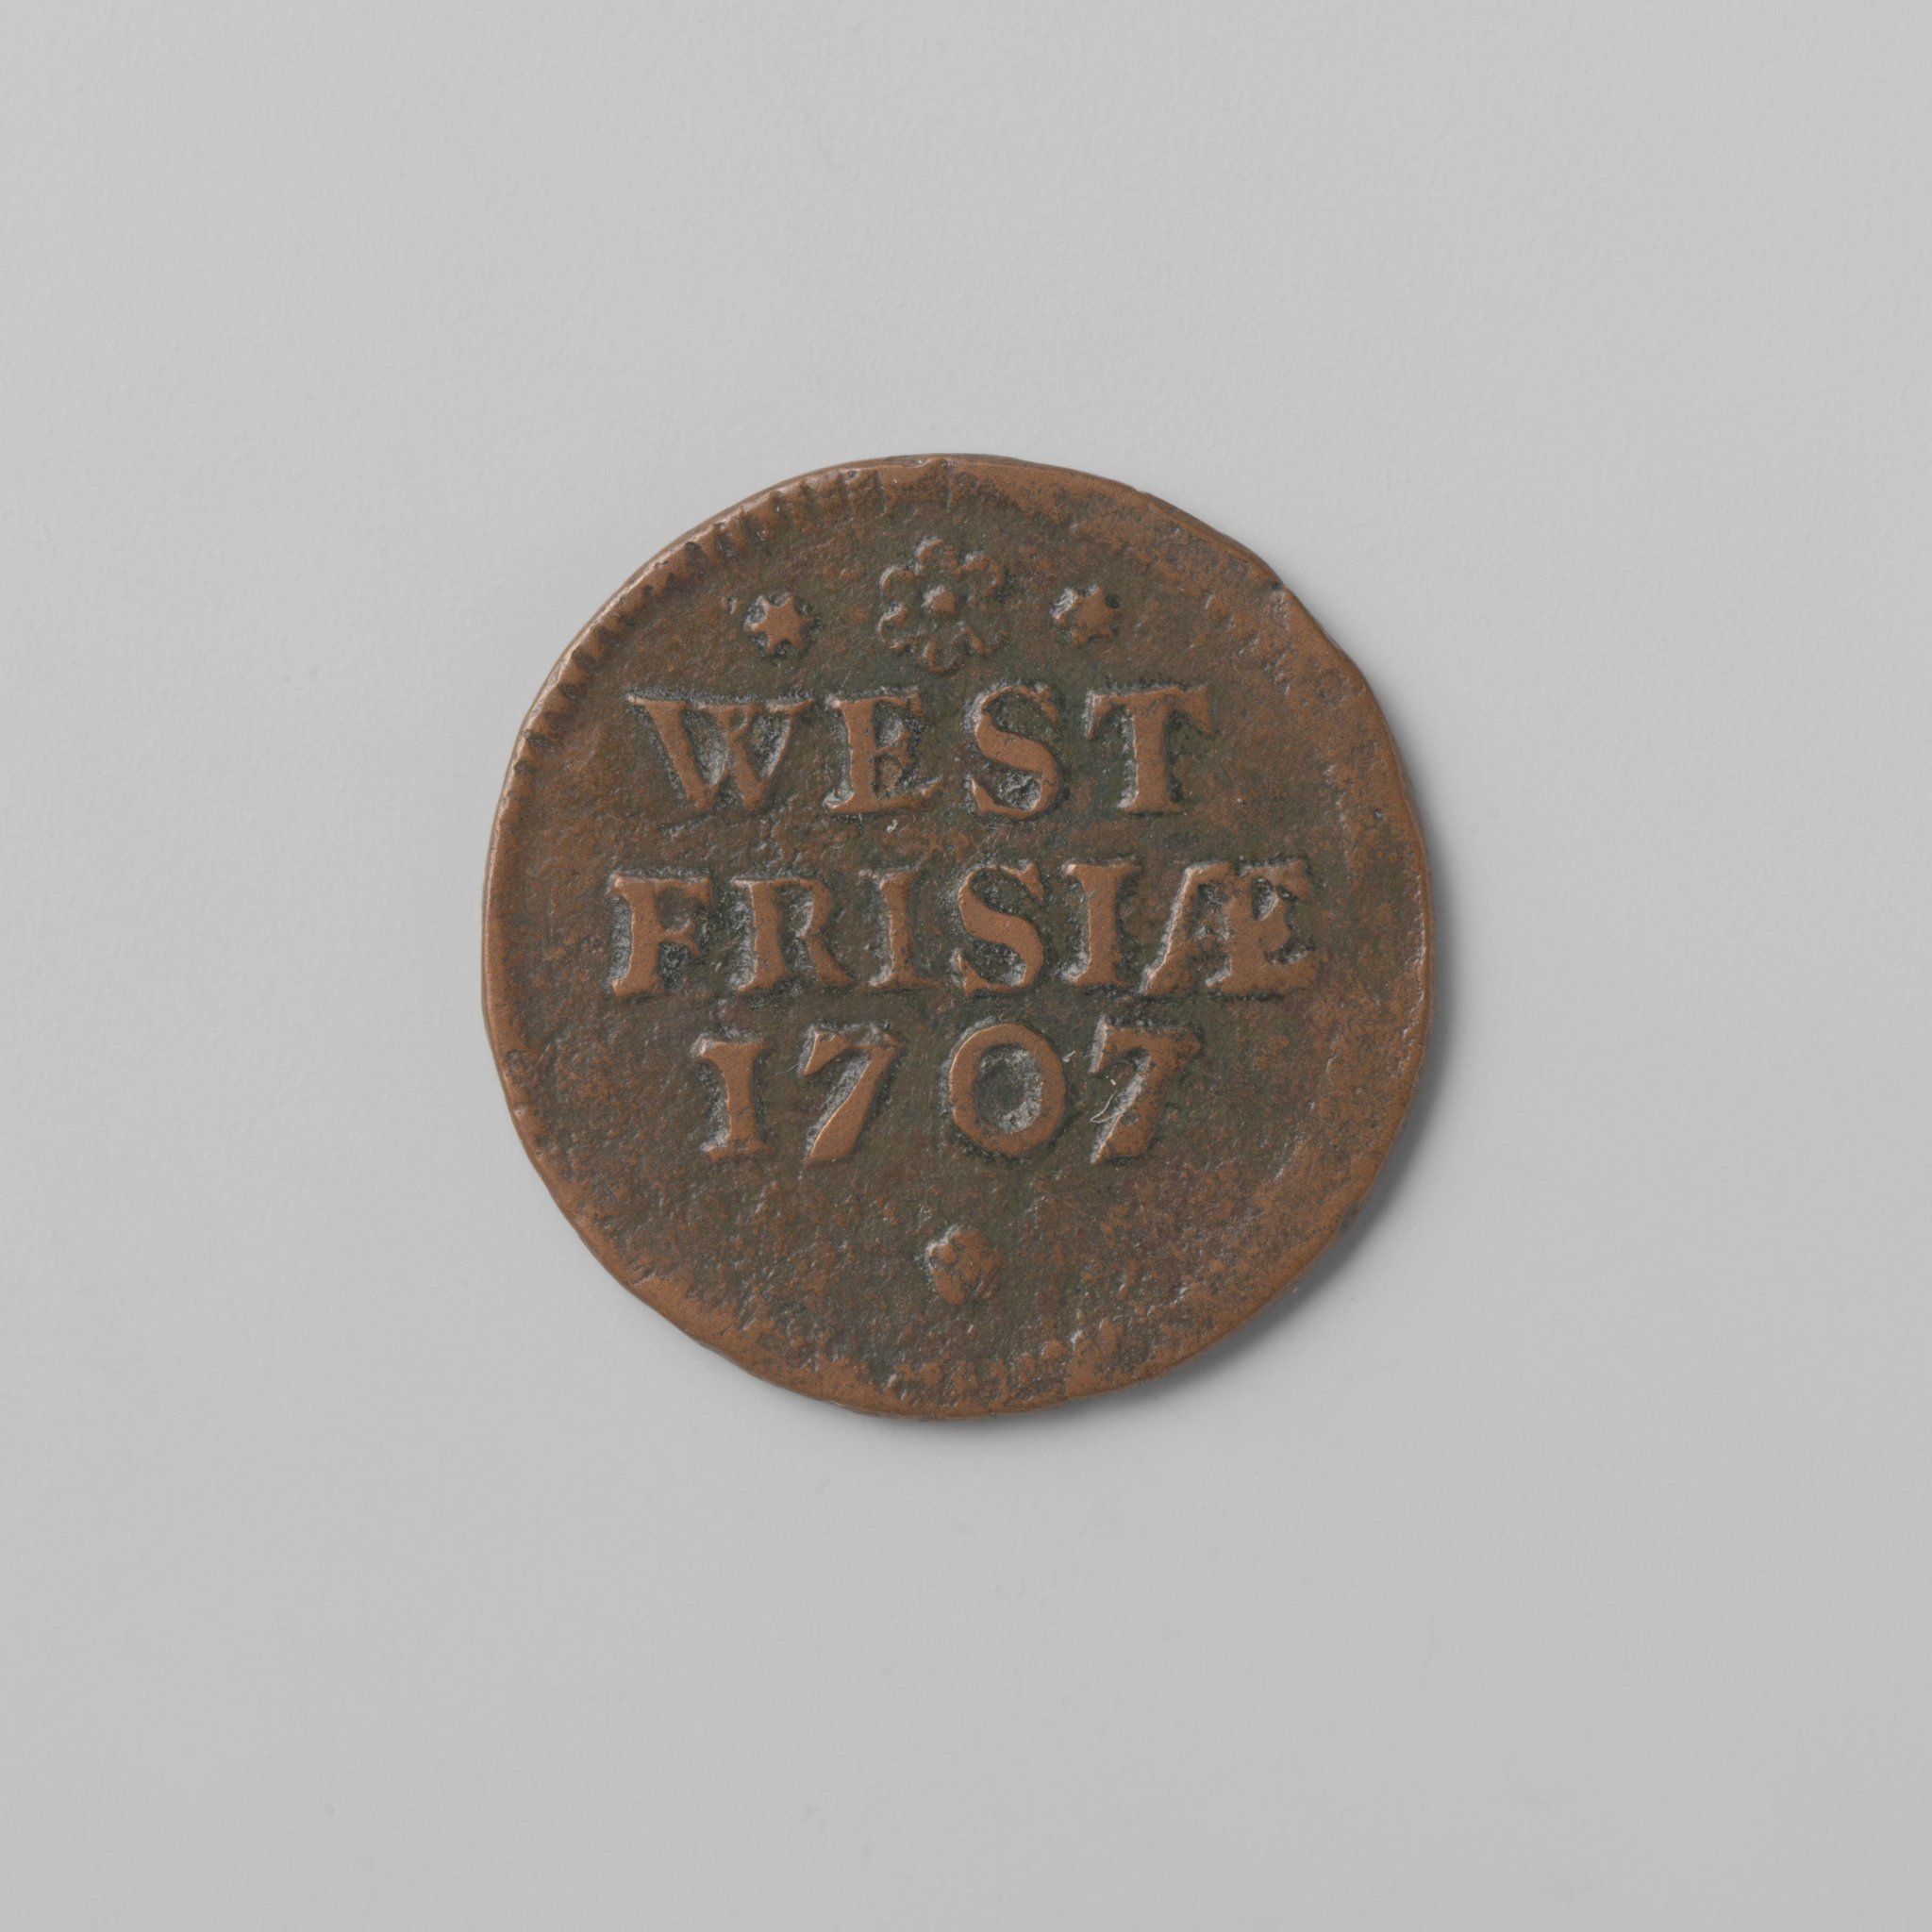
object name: coin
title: Westfriese duit, 1707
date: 1707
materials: copper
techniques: striking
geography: west frisia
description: Koperen munt. Voorzijde: gekroond wapenschild van West-Friesland met lauwertakken. Keerzijde: opschrift in twee regels. Daarboven muntmeesterteken rozet tussen twee sterretjes. Daaronder jaartal, waaronder ster.